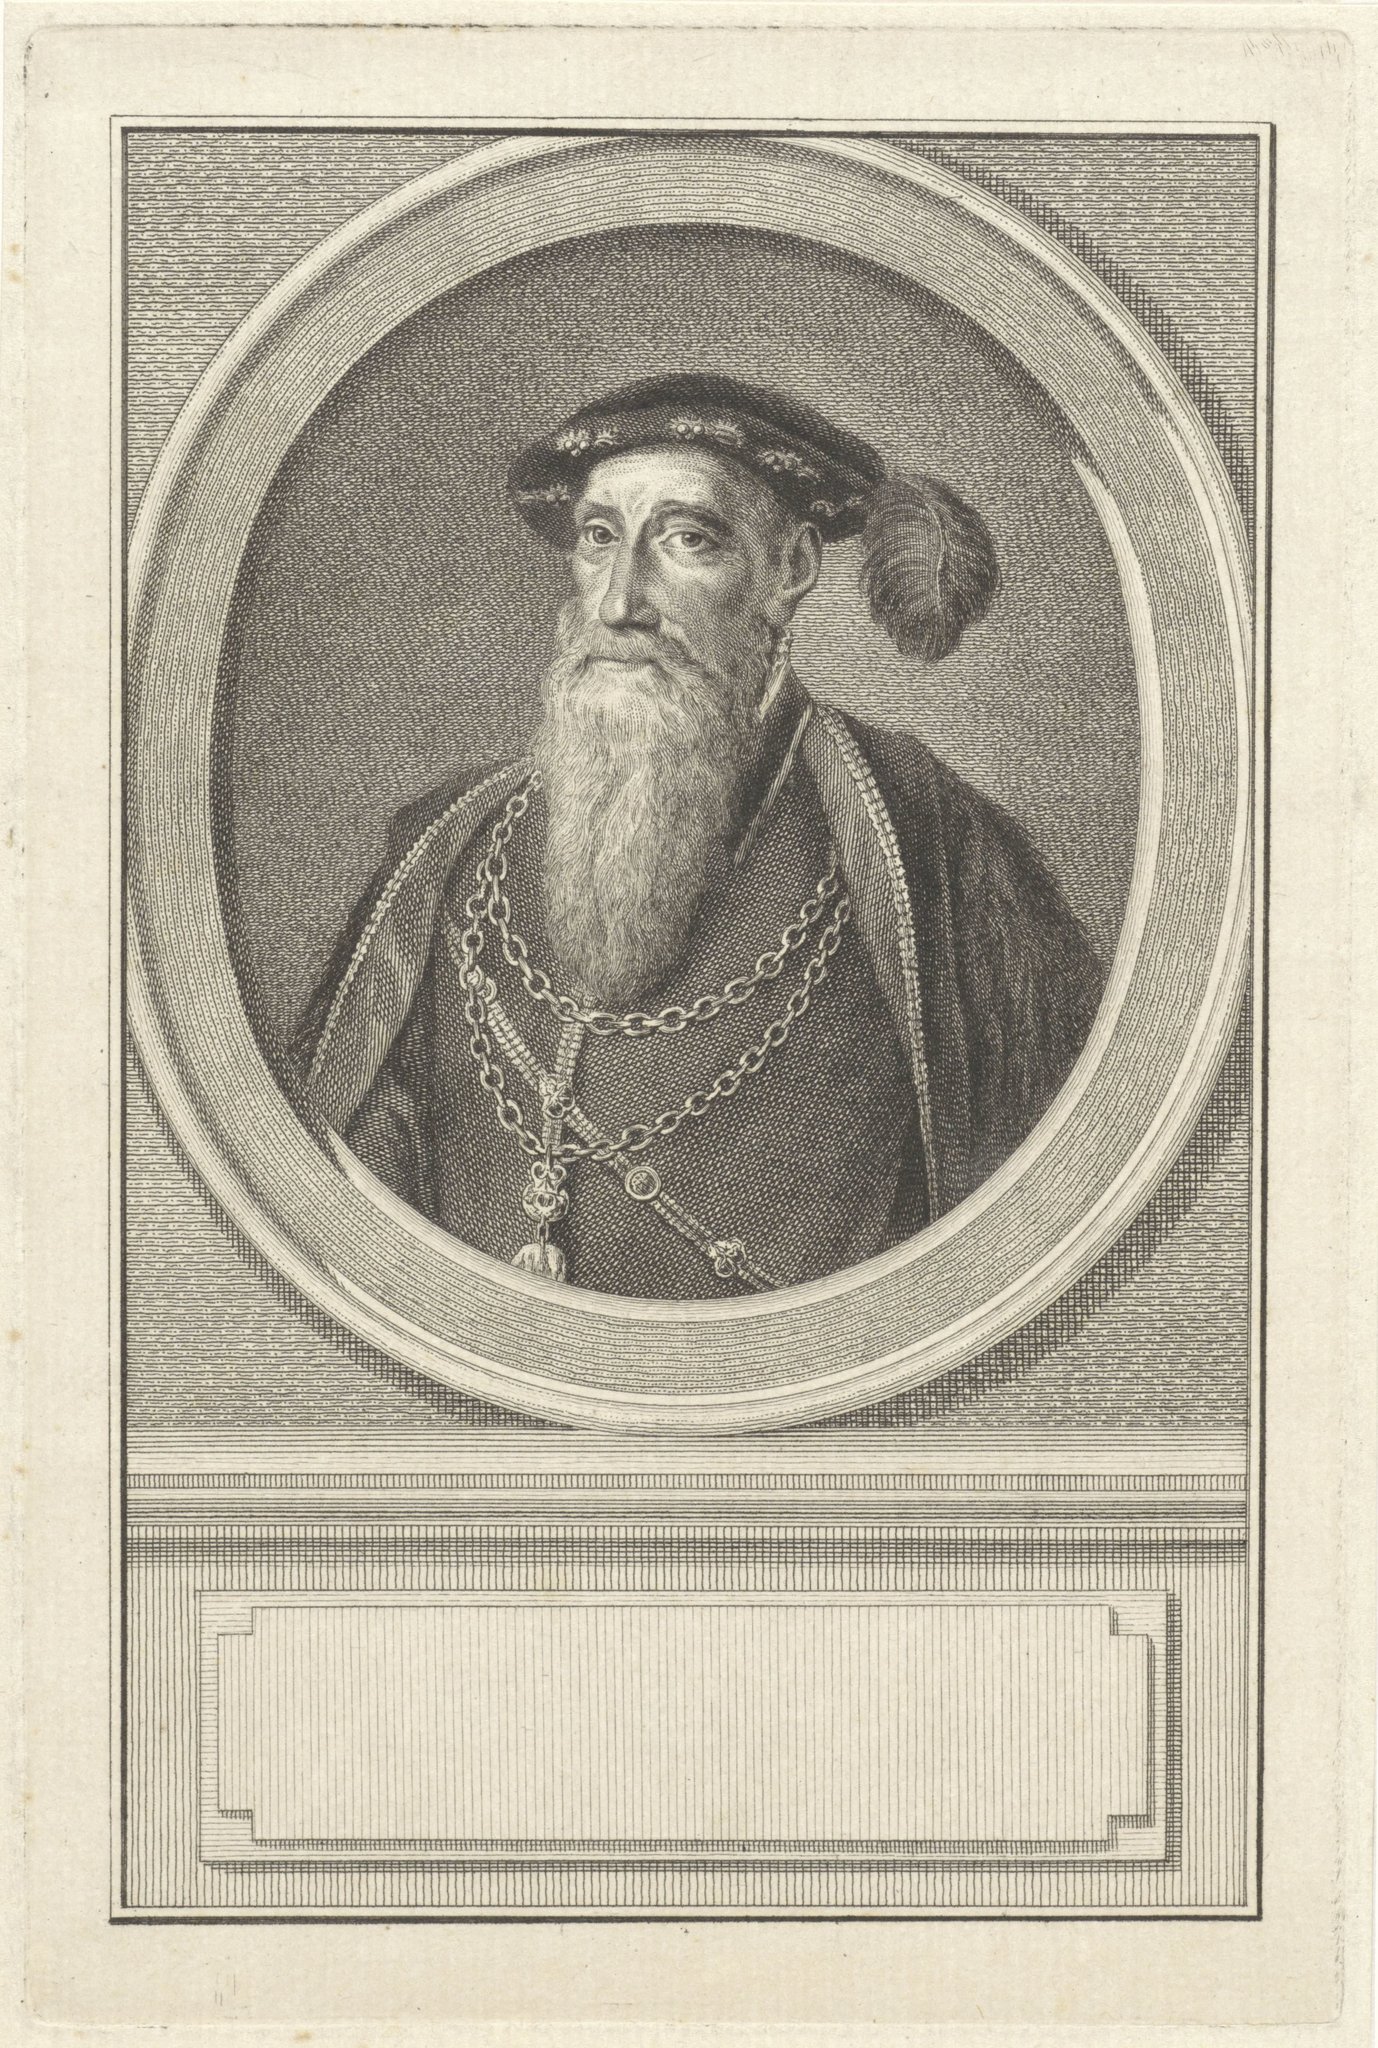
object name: print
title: Portret van Reinoud III van Brederode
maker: reinier vinkeles (i)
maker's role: draughtsman, print maker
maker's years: 1741-1816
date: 1758-1816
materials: paper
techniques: engraving, etching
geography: amsterdam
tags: brussels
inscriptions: collector's mark: Lugt 2228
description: Portret van Reinoud III van Brederode, ridder van het Gulden Vlies.